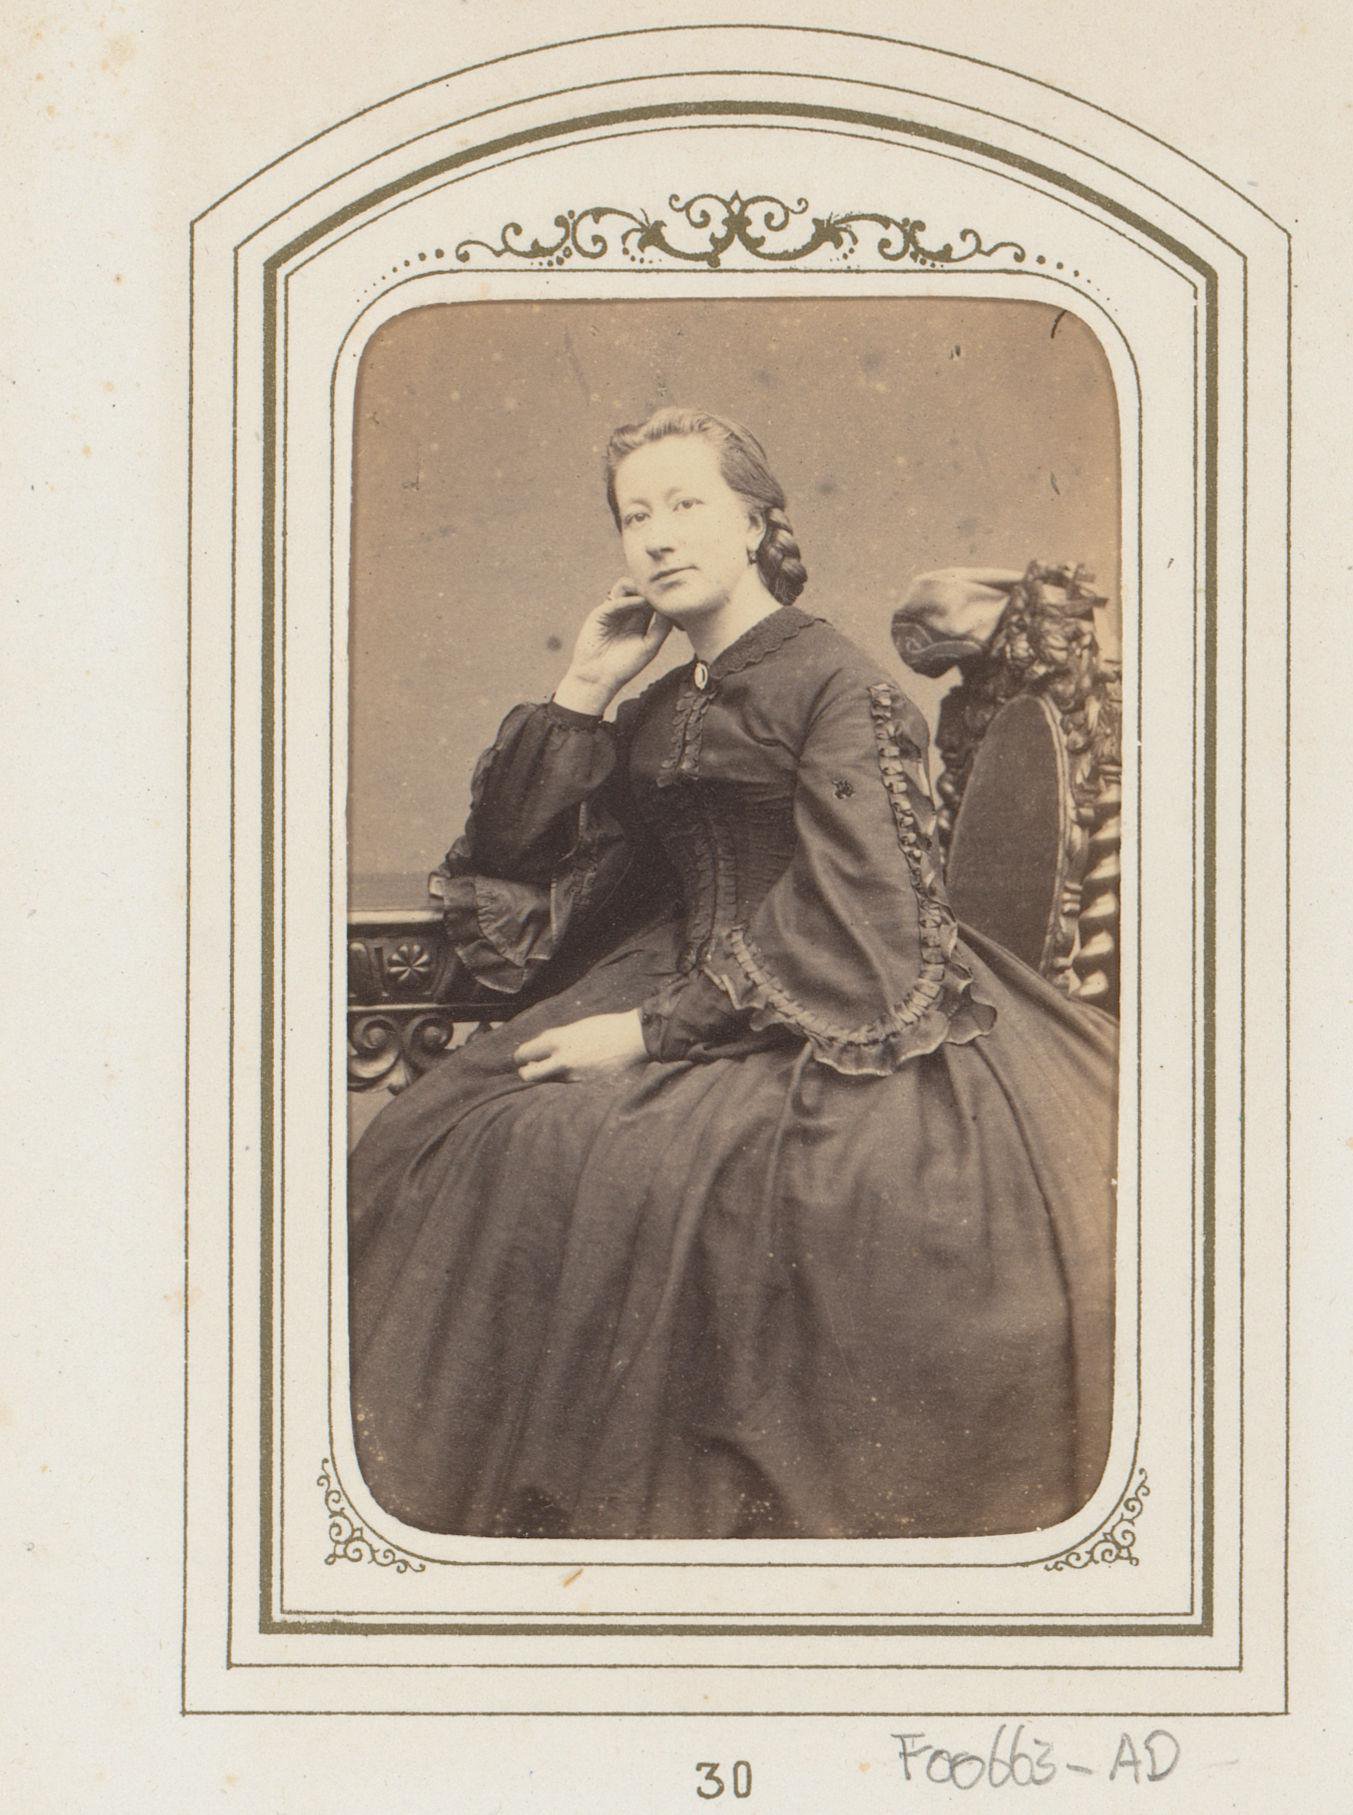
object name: album leaf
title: Portret van een zittende vrouw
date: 1857-1864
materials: cardboard, photographic support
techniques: albumen print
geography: amsterdam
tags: historical persons - bb - woman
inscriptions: number: ‘30’, inscription: ‘Photogr Atelier/ Wegner & Mottu/ Prinsengracht BB.439/ Amsterdam’